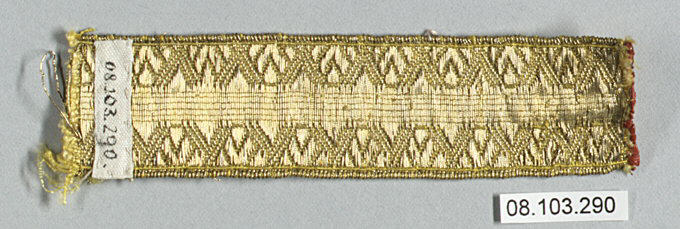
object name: galloon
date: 1601-1800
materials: metal thread, silk